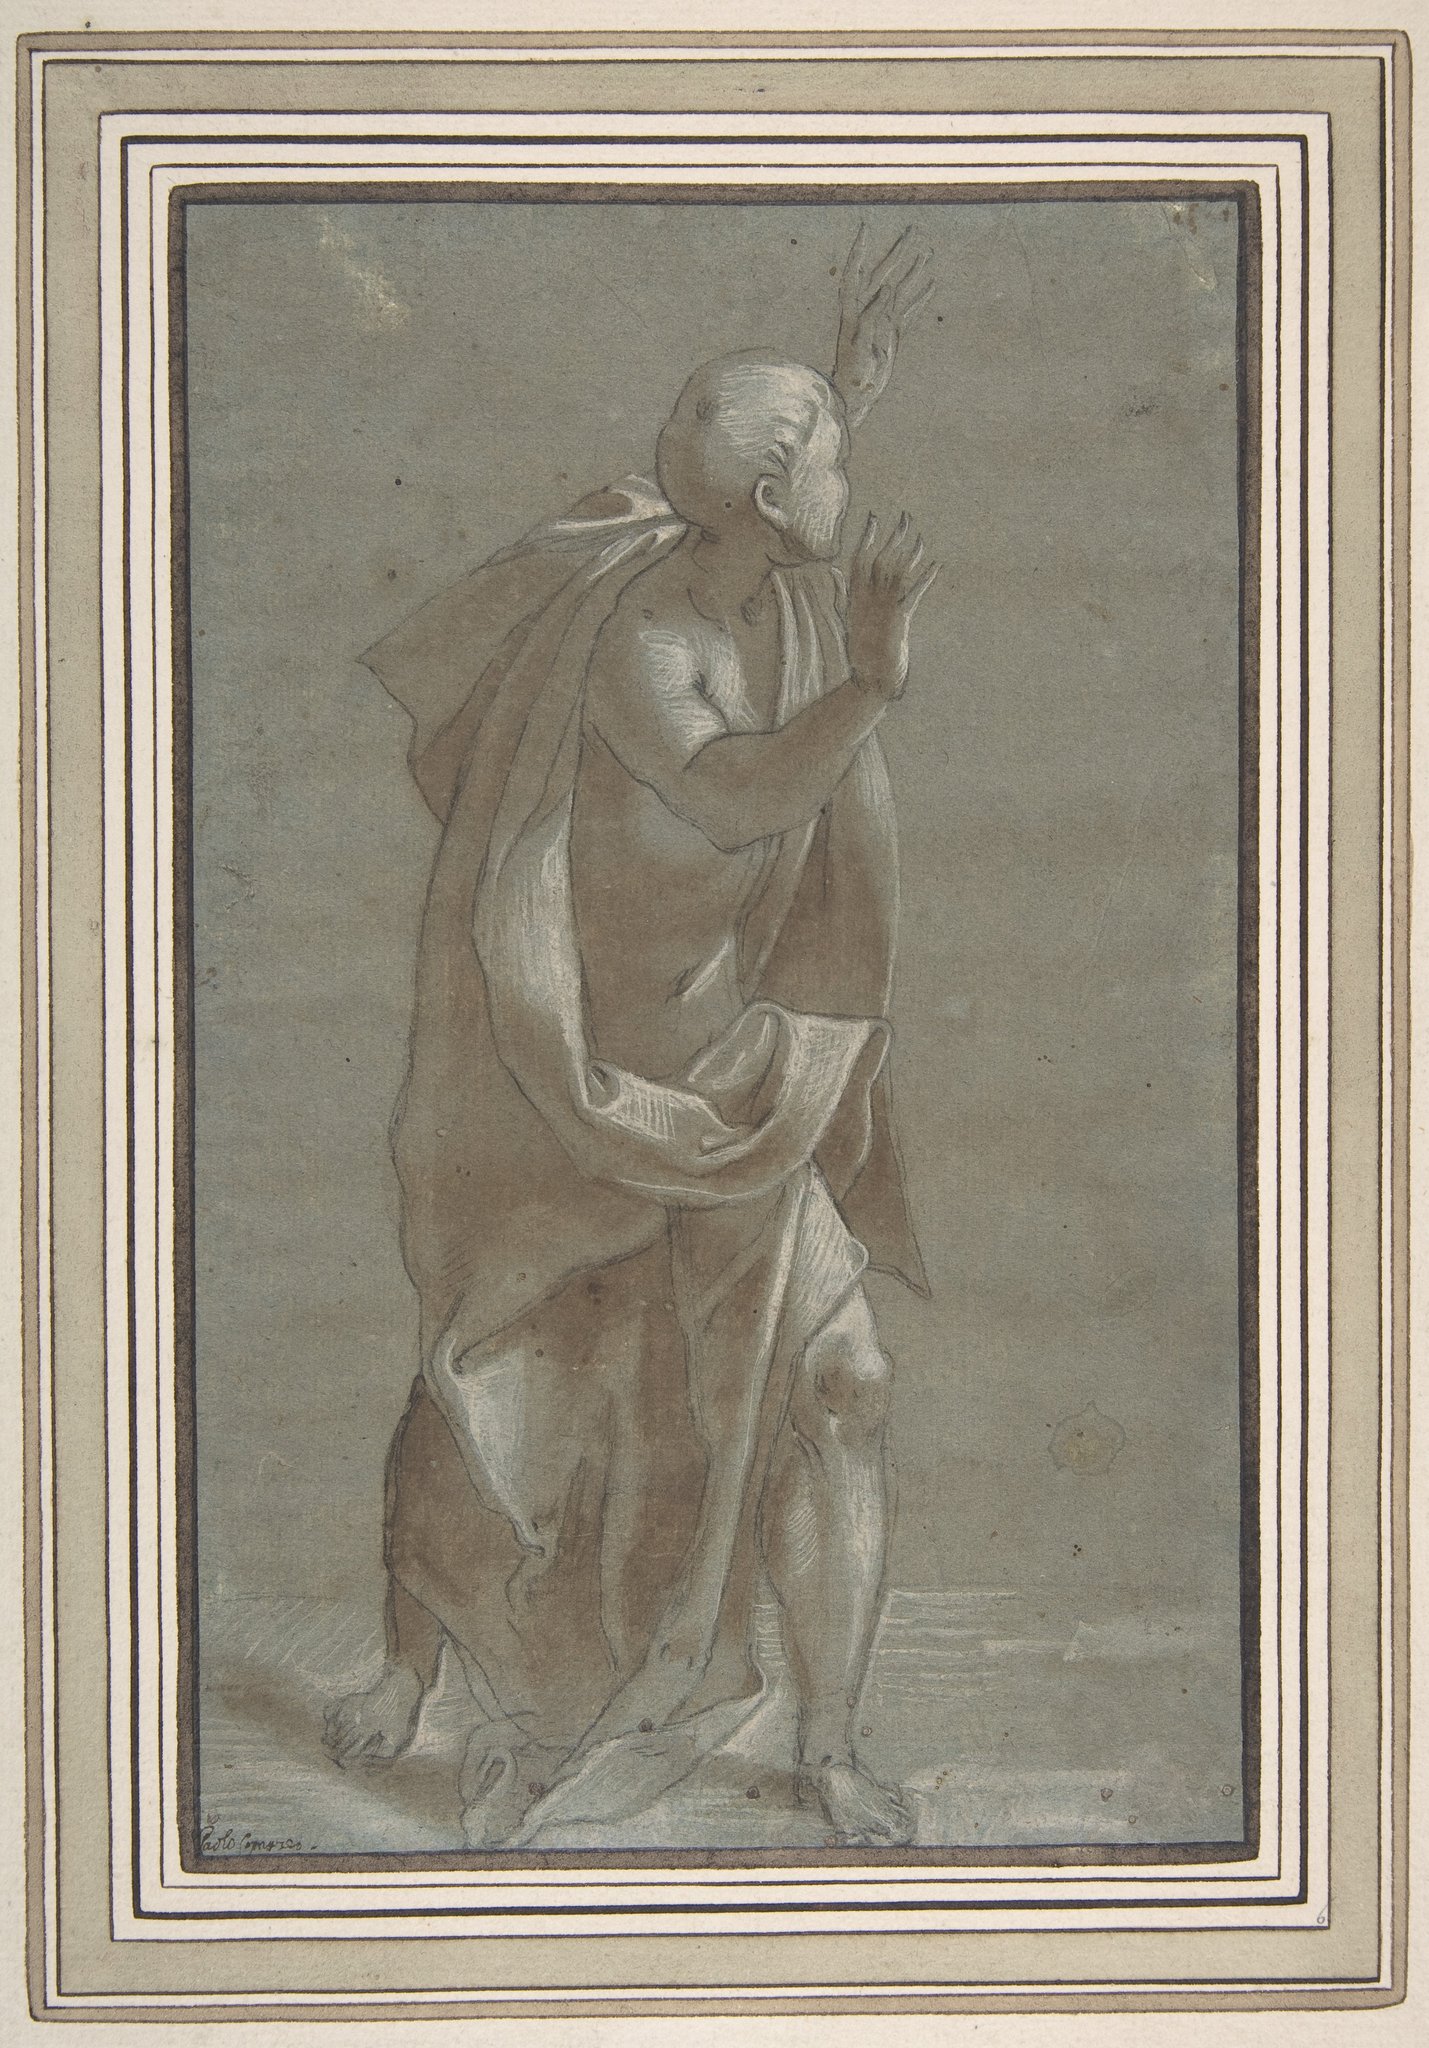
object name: drawing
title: Standing Male Draped Figure With His Hands Raised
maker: giovanni paolo lomazzo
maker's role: artist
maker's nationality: italian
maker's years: 1538-1600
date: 1565-1571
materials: chalk, gouache, paper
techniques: brush, highlighting, wash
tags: men